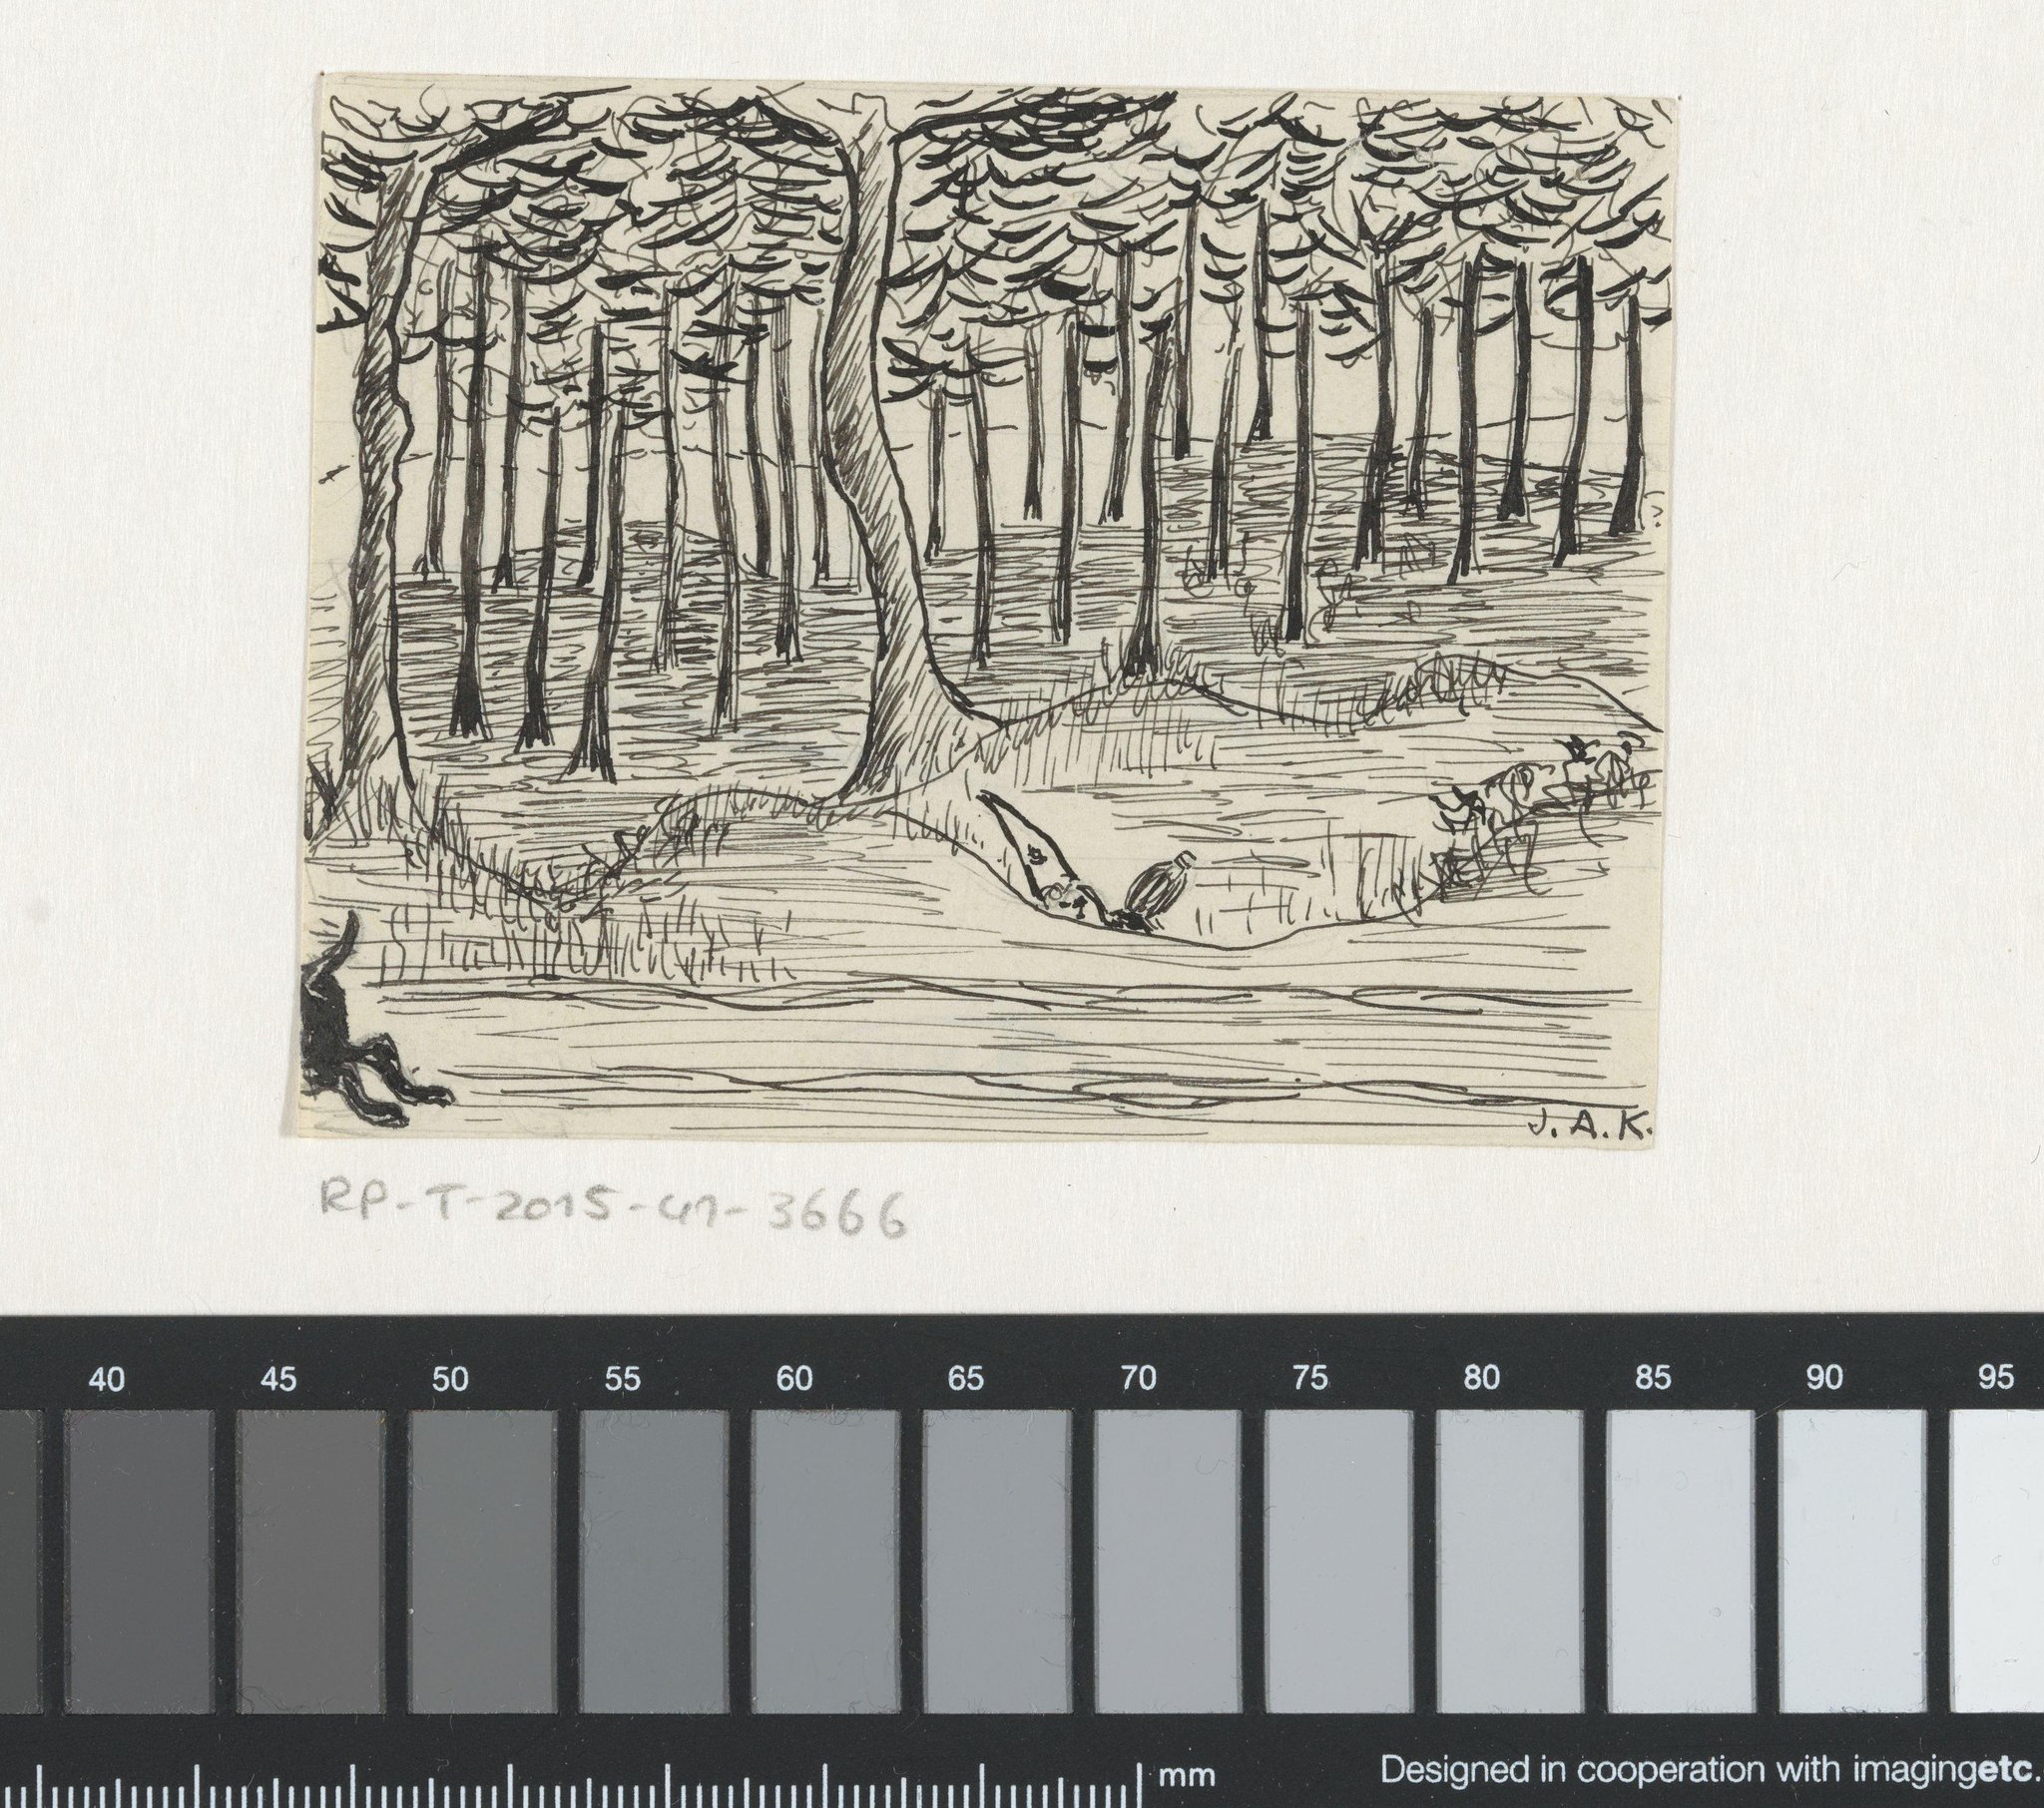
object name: boekillustratie ontwerp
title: Pop in een kuil in een bos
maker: Anonymous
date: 1880-1930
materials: ink, pencil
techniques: pen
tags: (playing with) dolls, bed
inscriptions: :, annotation: ‘Maart pag. 5.’, signature: ‘J.A.K.’, number: ‘336’, collector's mark: Lugt 2228a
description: Een pop steekt met zijn hoofd boven een kuil aan de rand van een bos uit. Links zijn de achterpoten van een wegrennende hond te zien